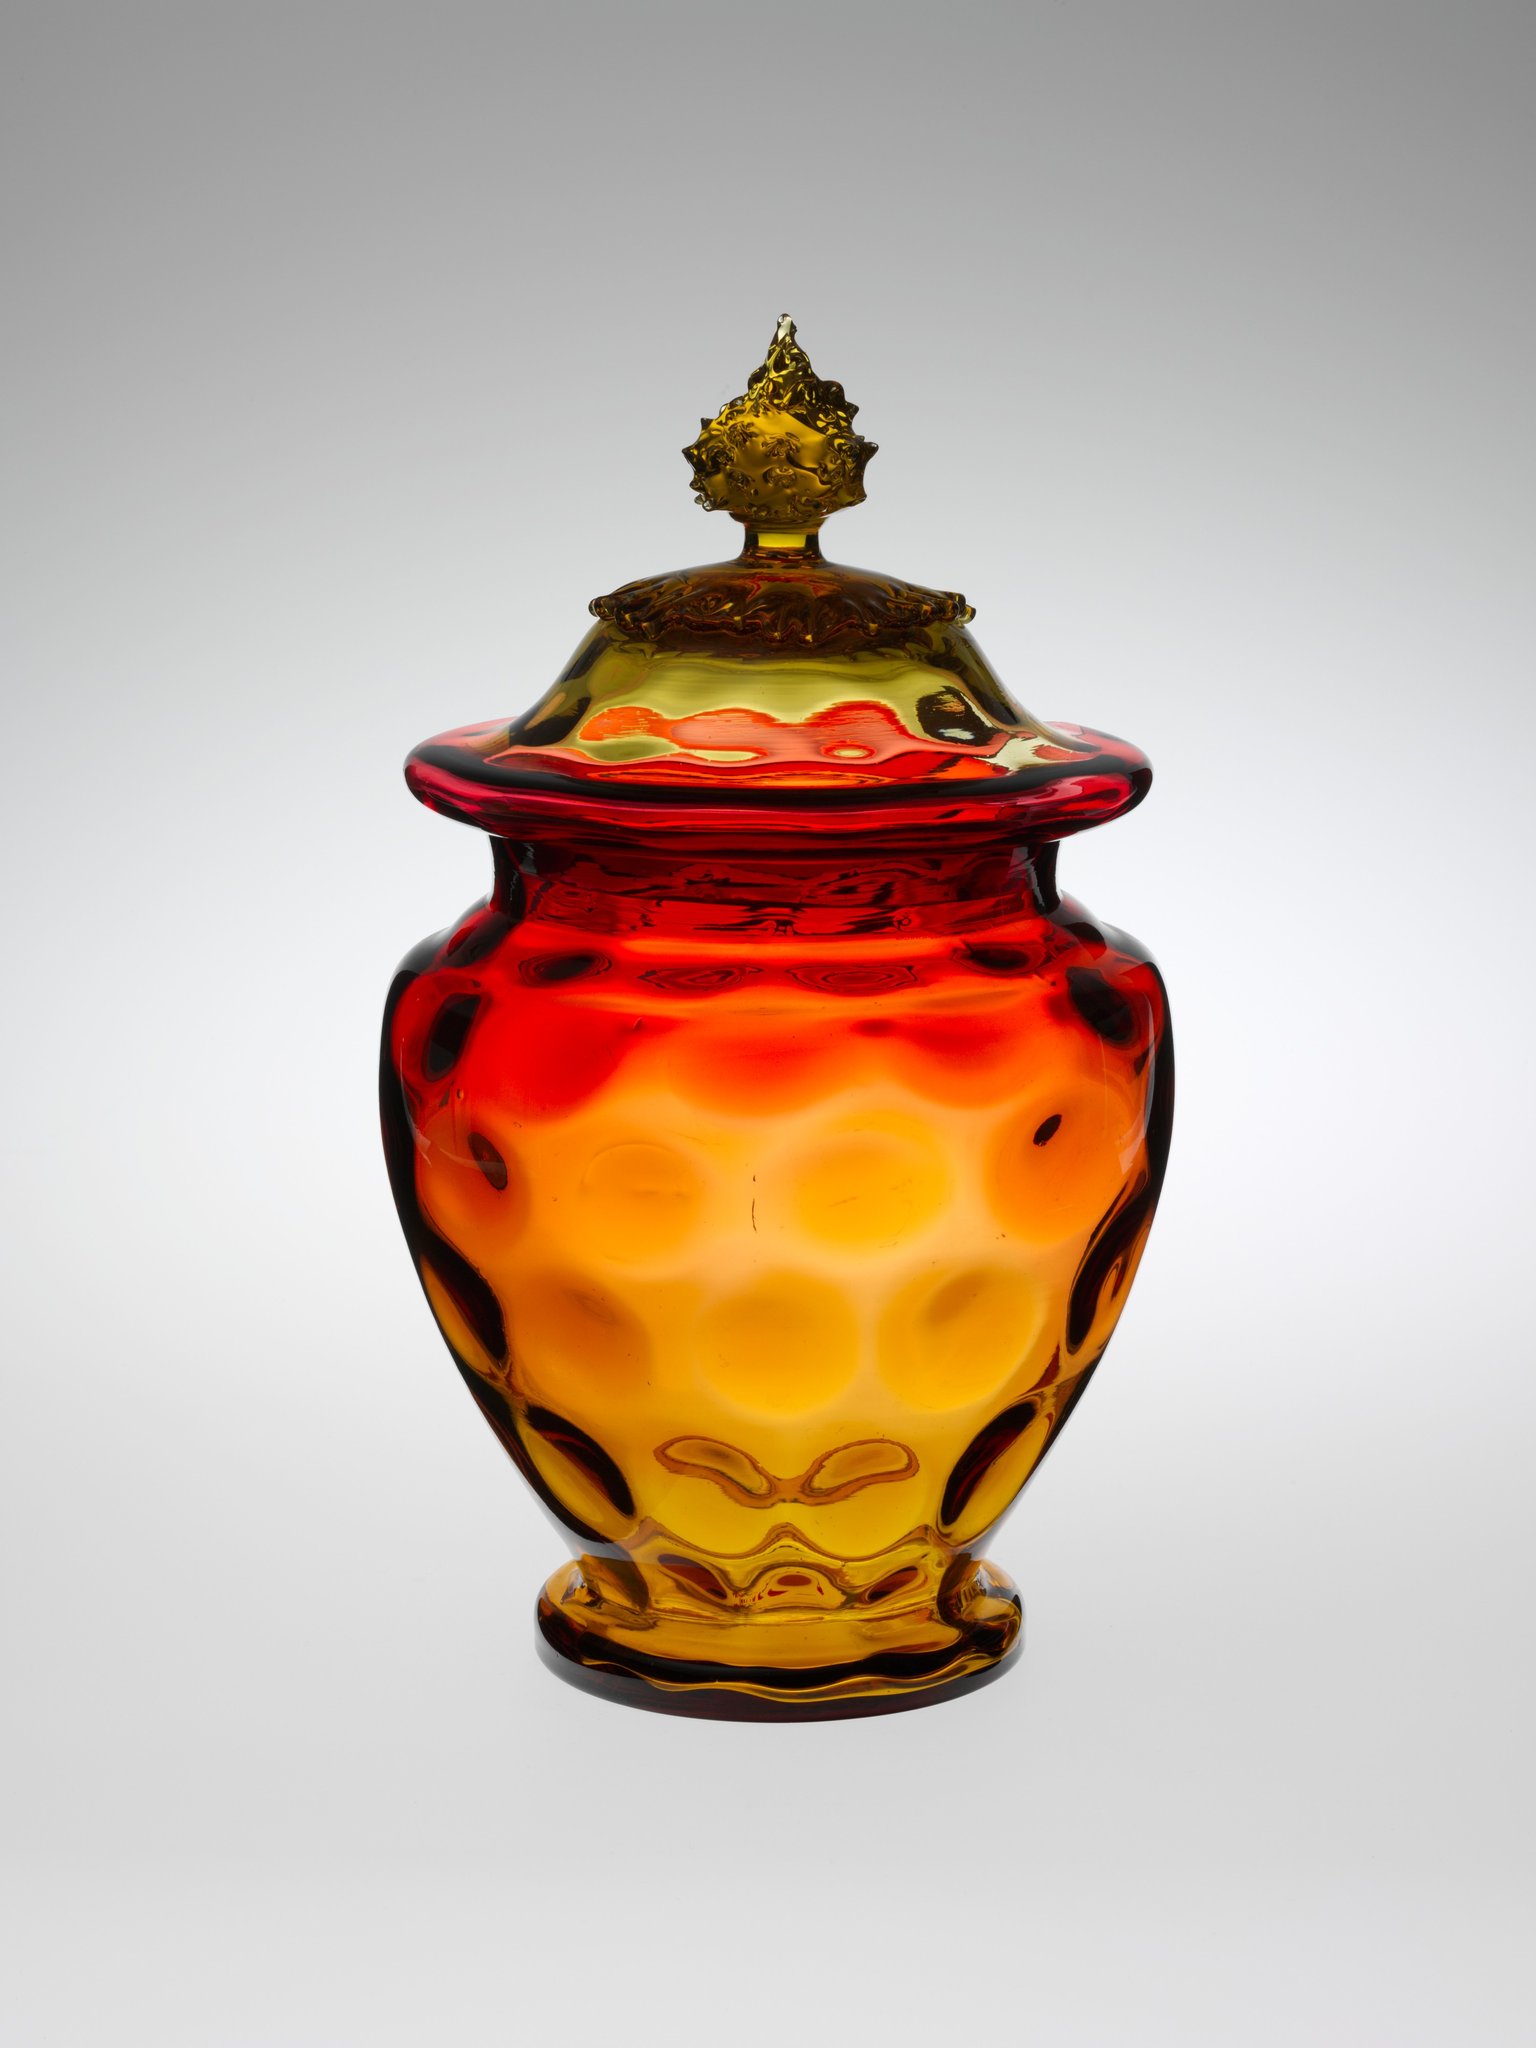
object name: punch bowl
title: Covered Punch Bowl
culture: american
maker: hobbs, brockunier and company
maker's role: maker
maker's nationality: american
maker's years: 1863-1891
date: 1885-1887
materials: glass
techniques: glassblowing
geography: united states